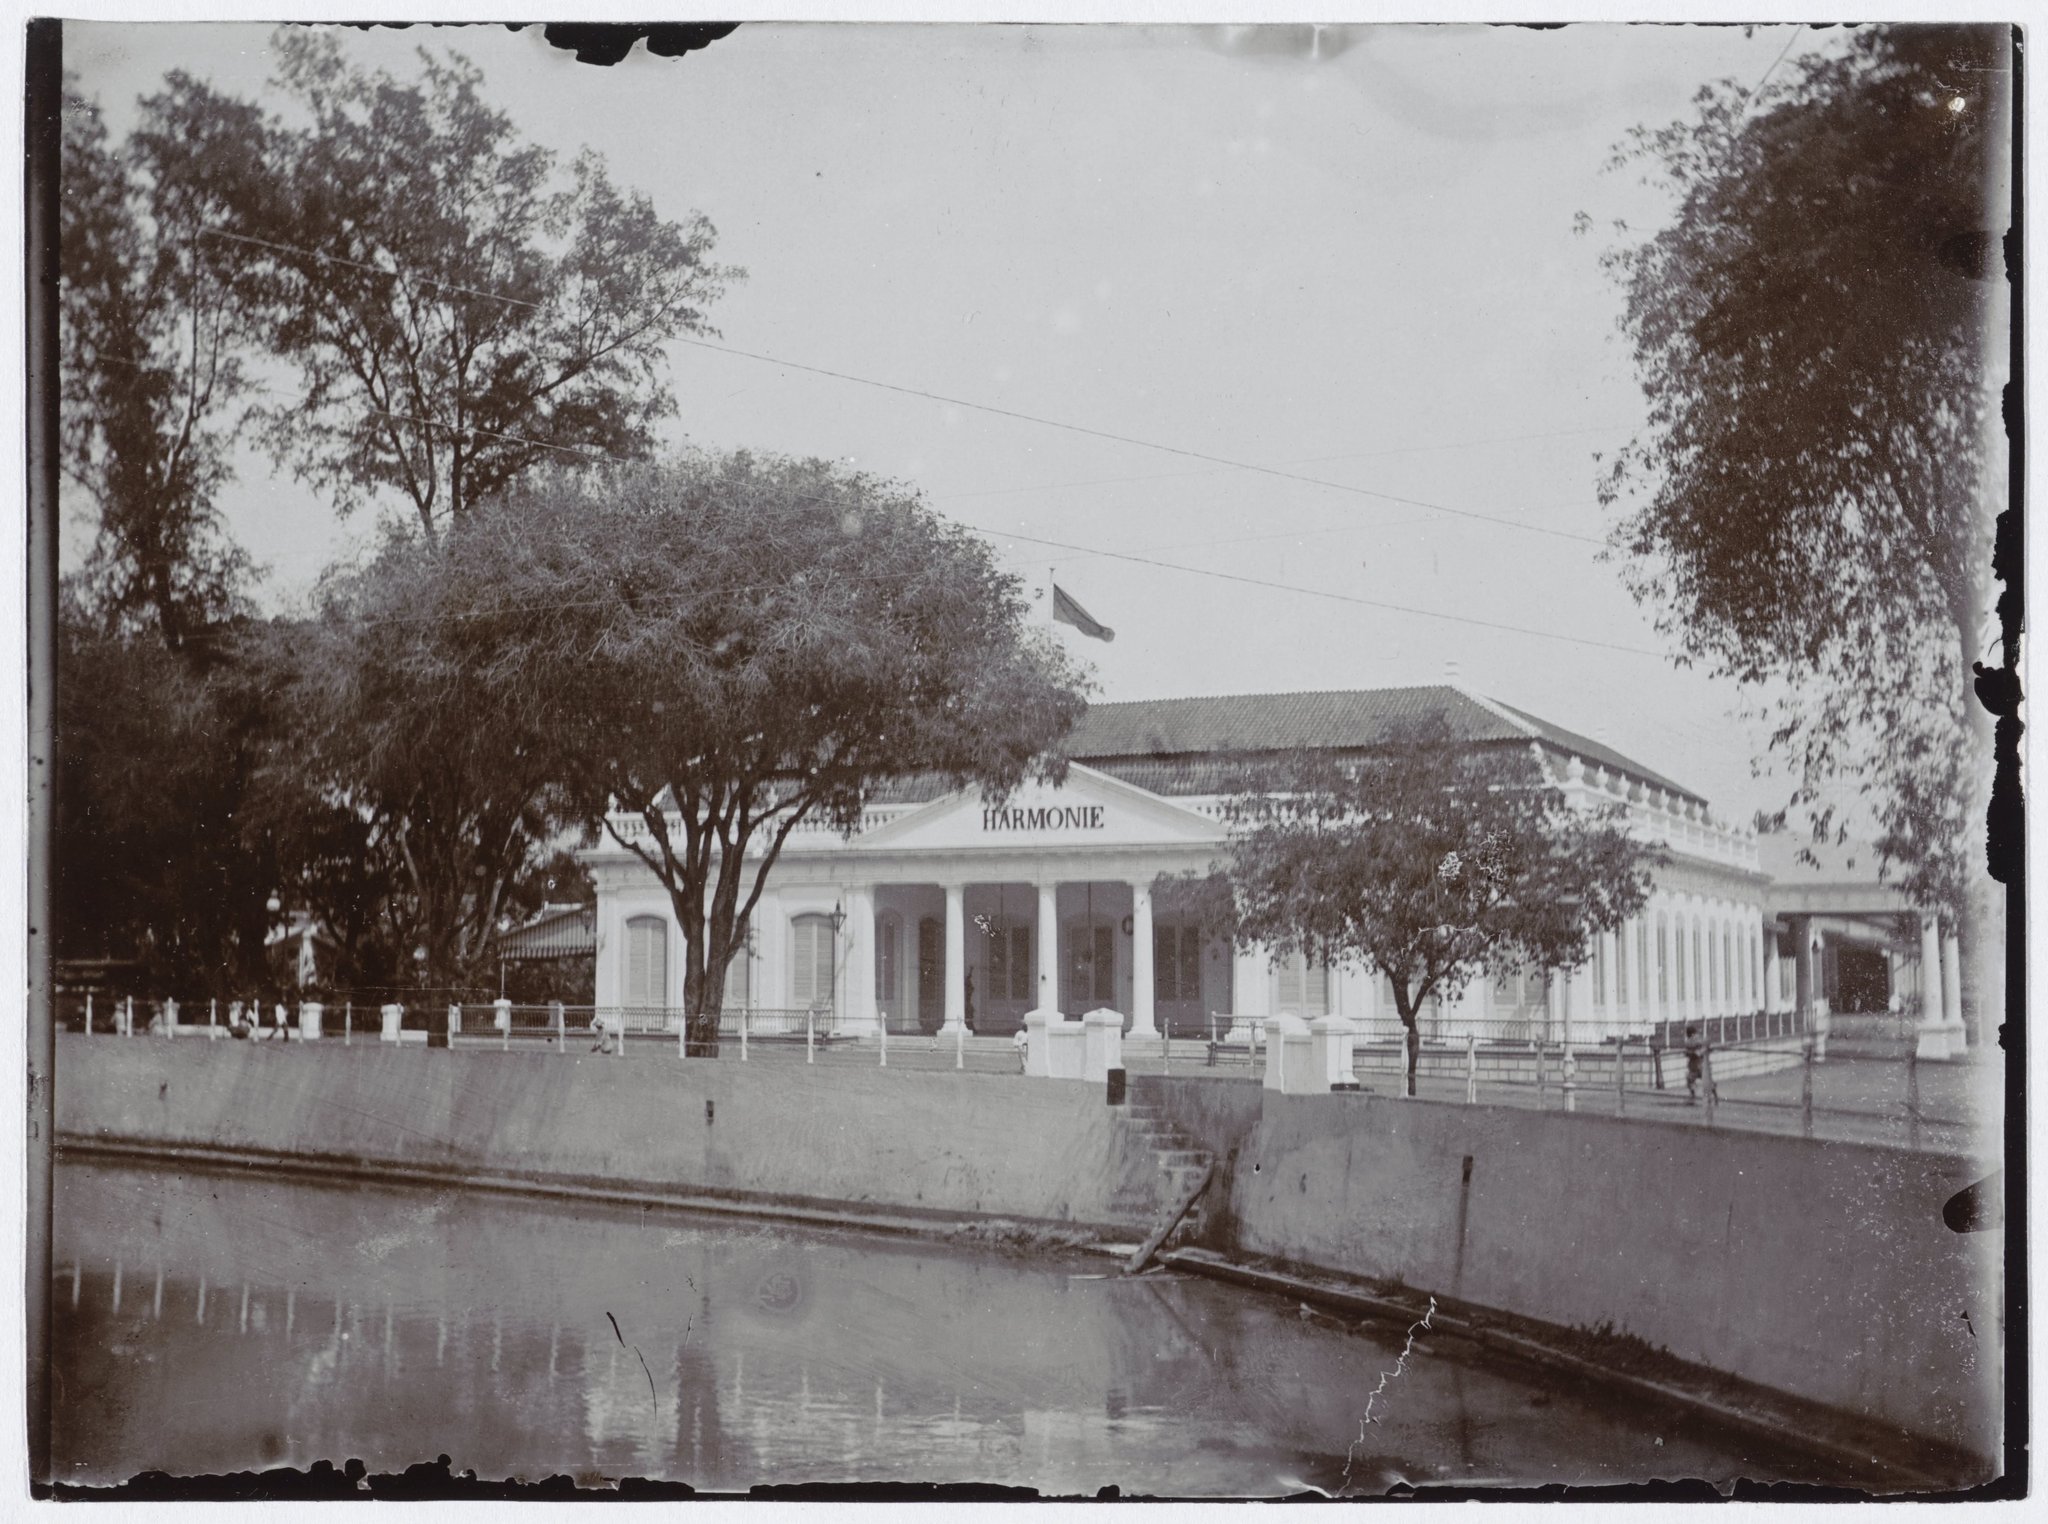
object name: photograph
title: Societeit de Harmonie in Jakarta.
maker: johanna hermina marmelstein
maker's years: 1897-1990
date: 1900-1915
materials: paper, photographic support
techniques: albumen print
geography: jakarta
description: Societeit de Harmonie in Jakarta, het gebouw is in 1985 afgebroken.